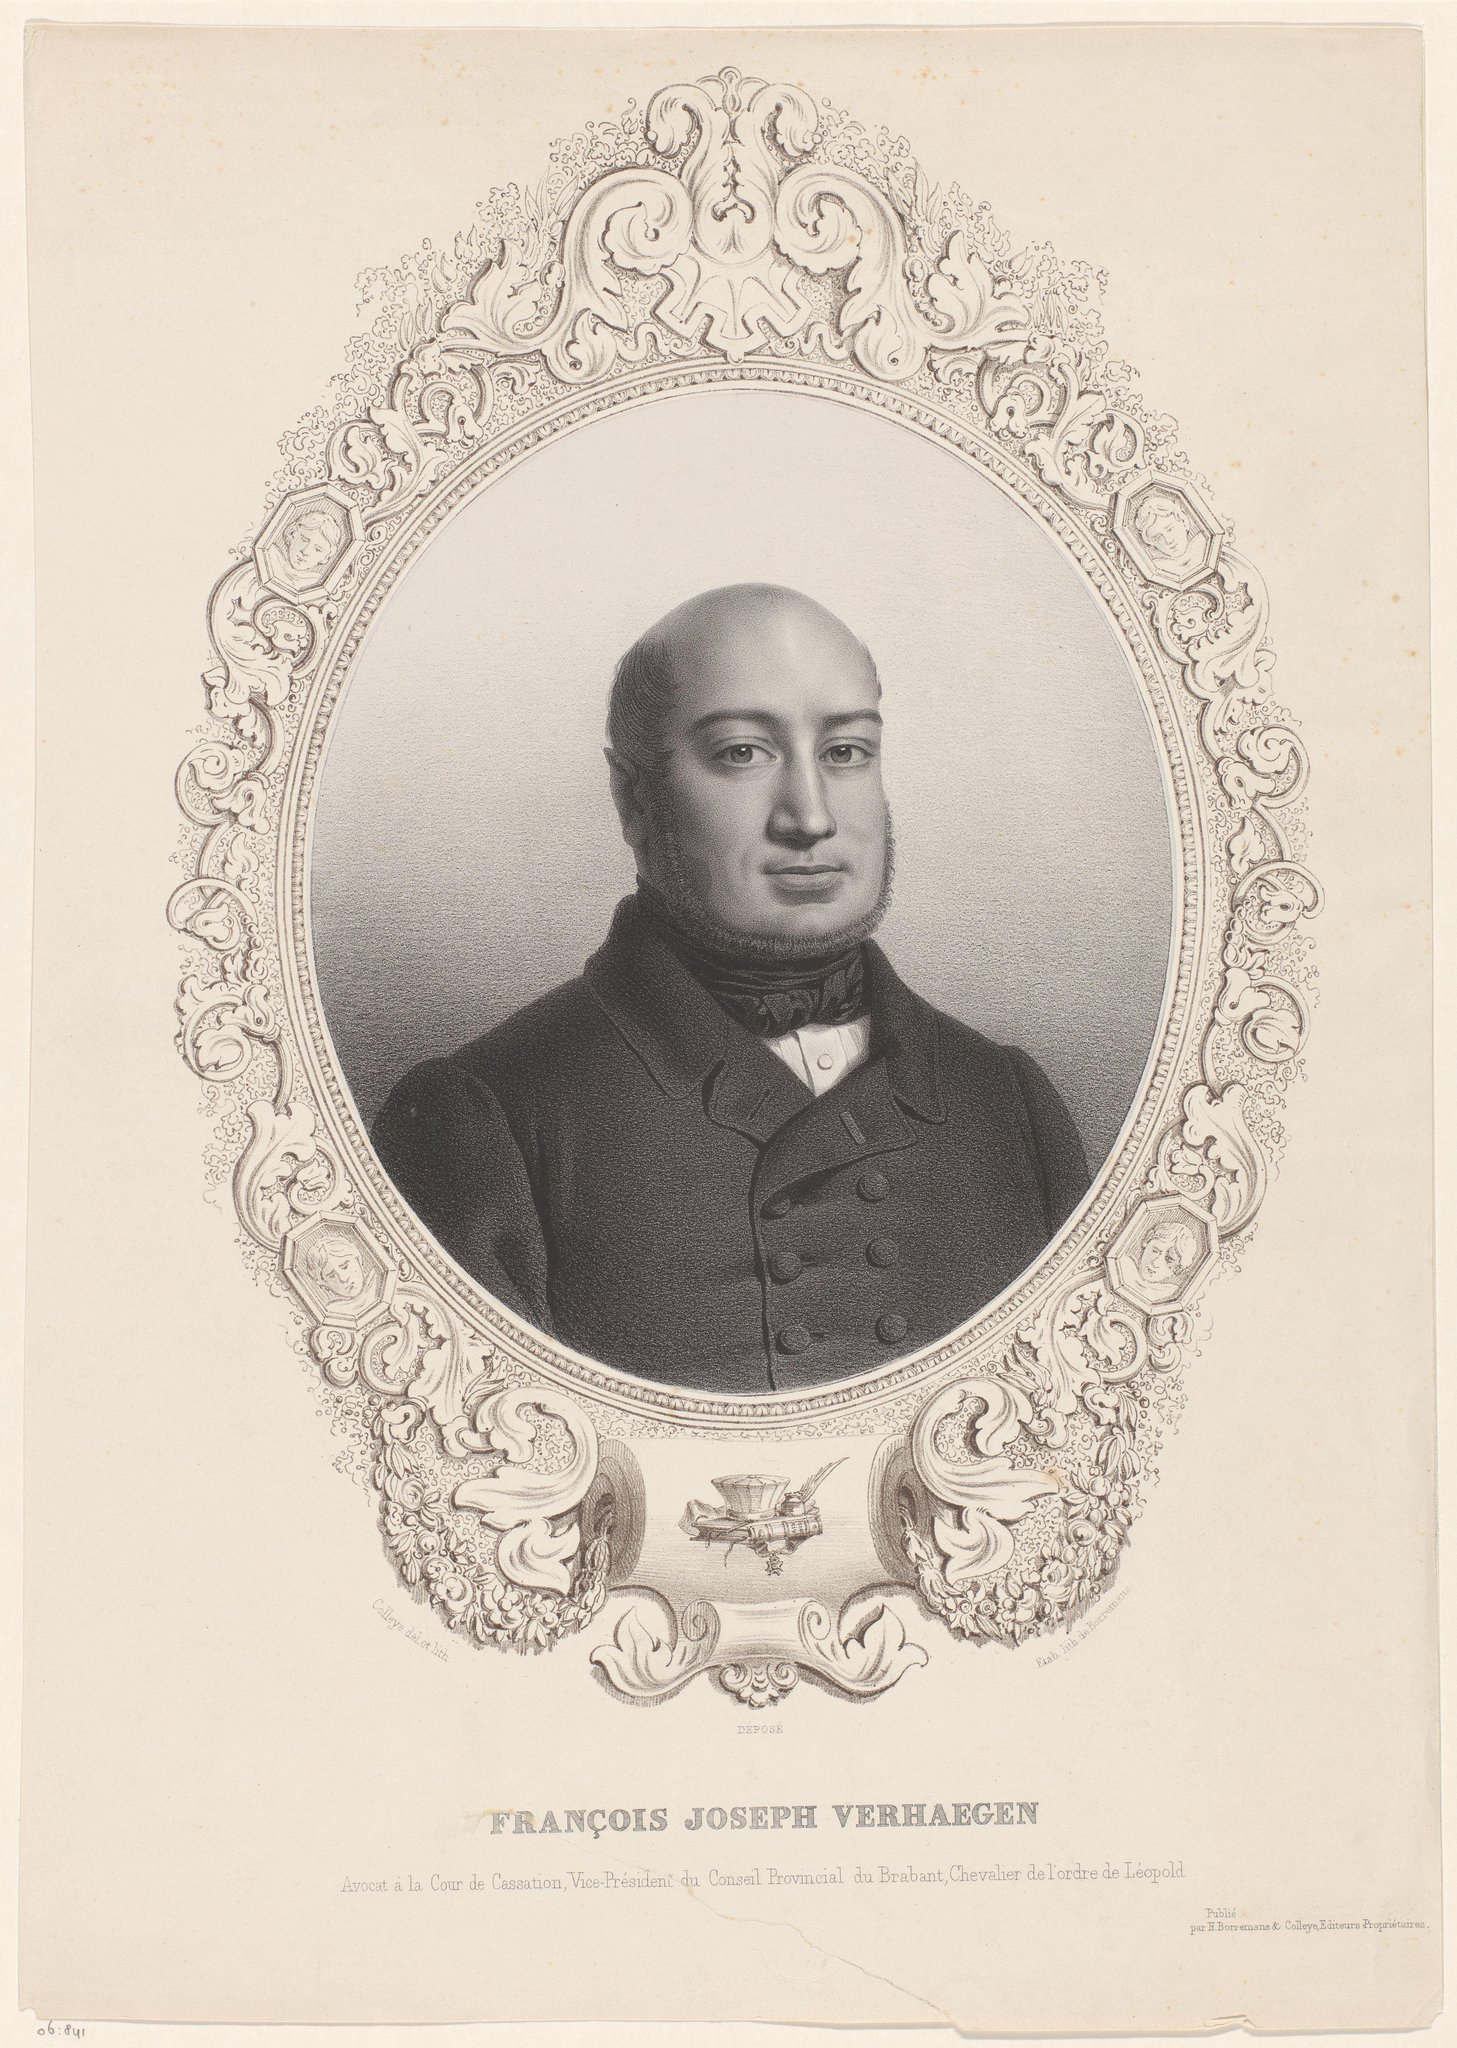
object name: print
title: Portret van François Joseph Verhaegen in ornamenteel kader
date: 1834-1862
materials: paper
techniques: lithograph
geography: brussels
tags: adult man, historical persons, ornament ~ cartouche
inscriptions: collector's mark: Lugt 2228, check stamp: ‘HB’, : ‘Déposé’